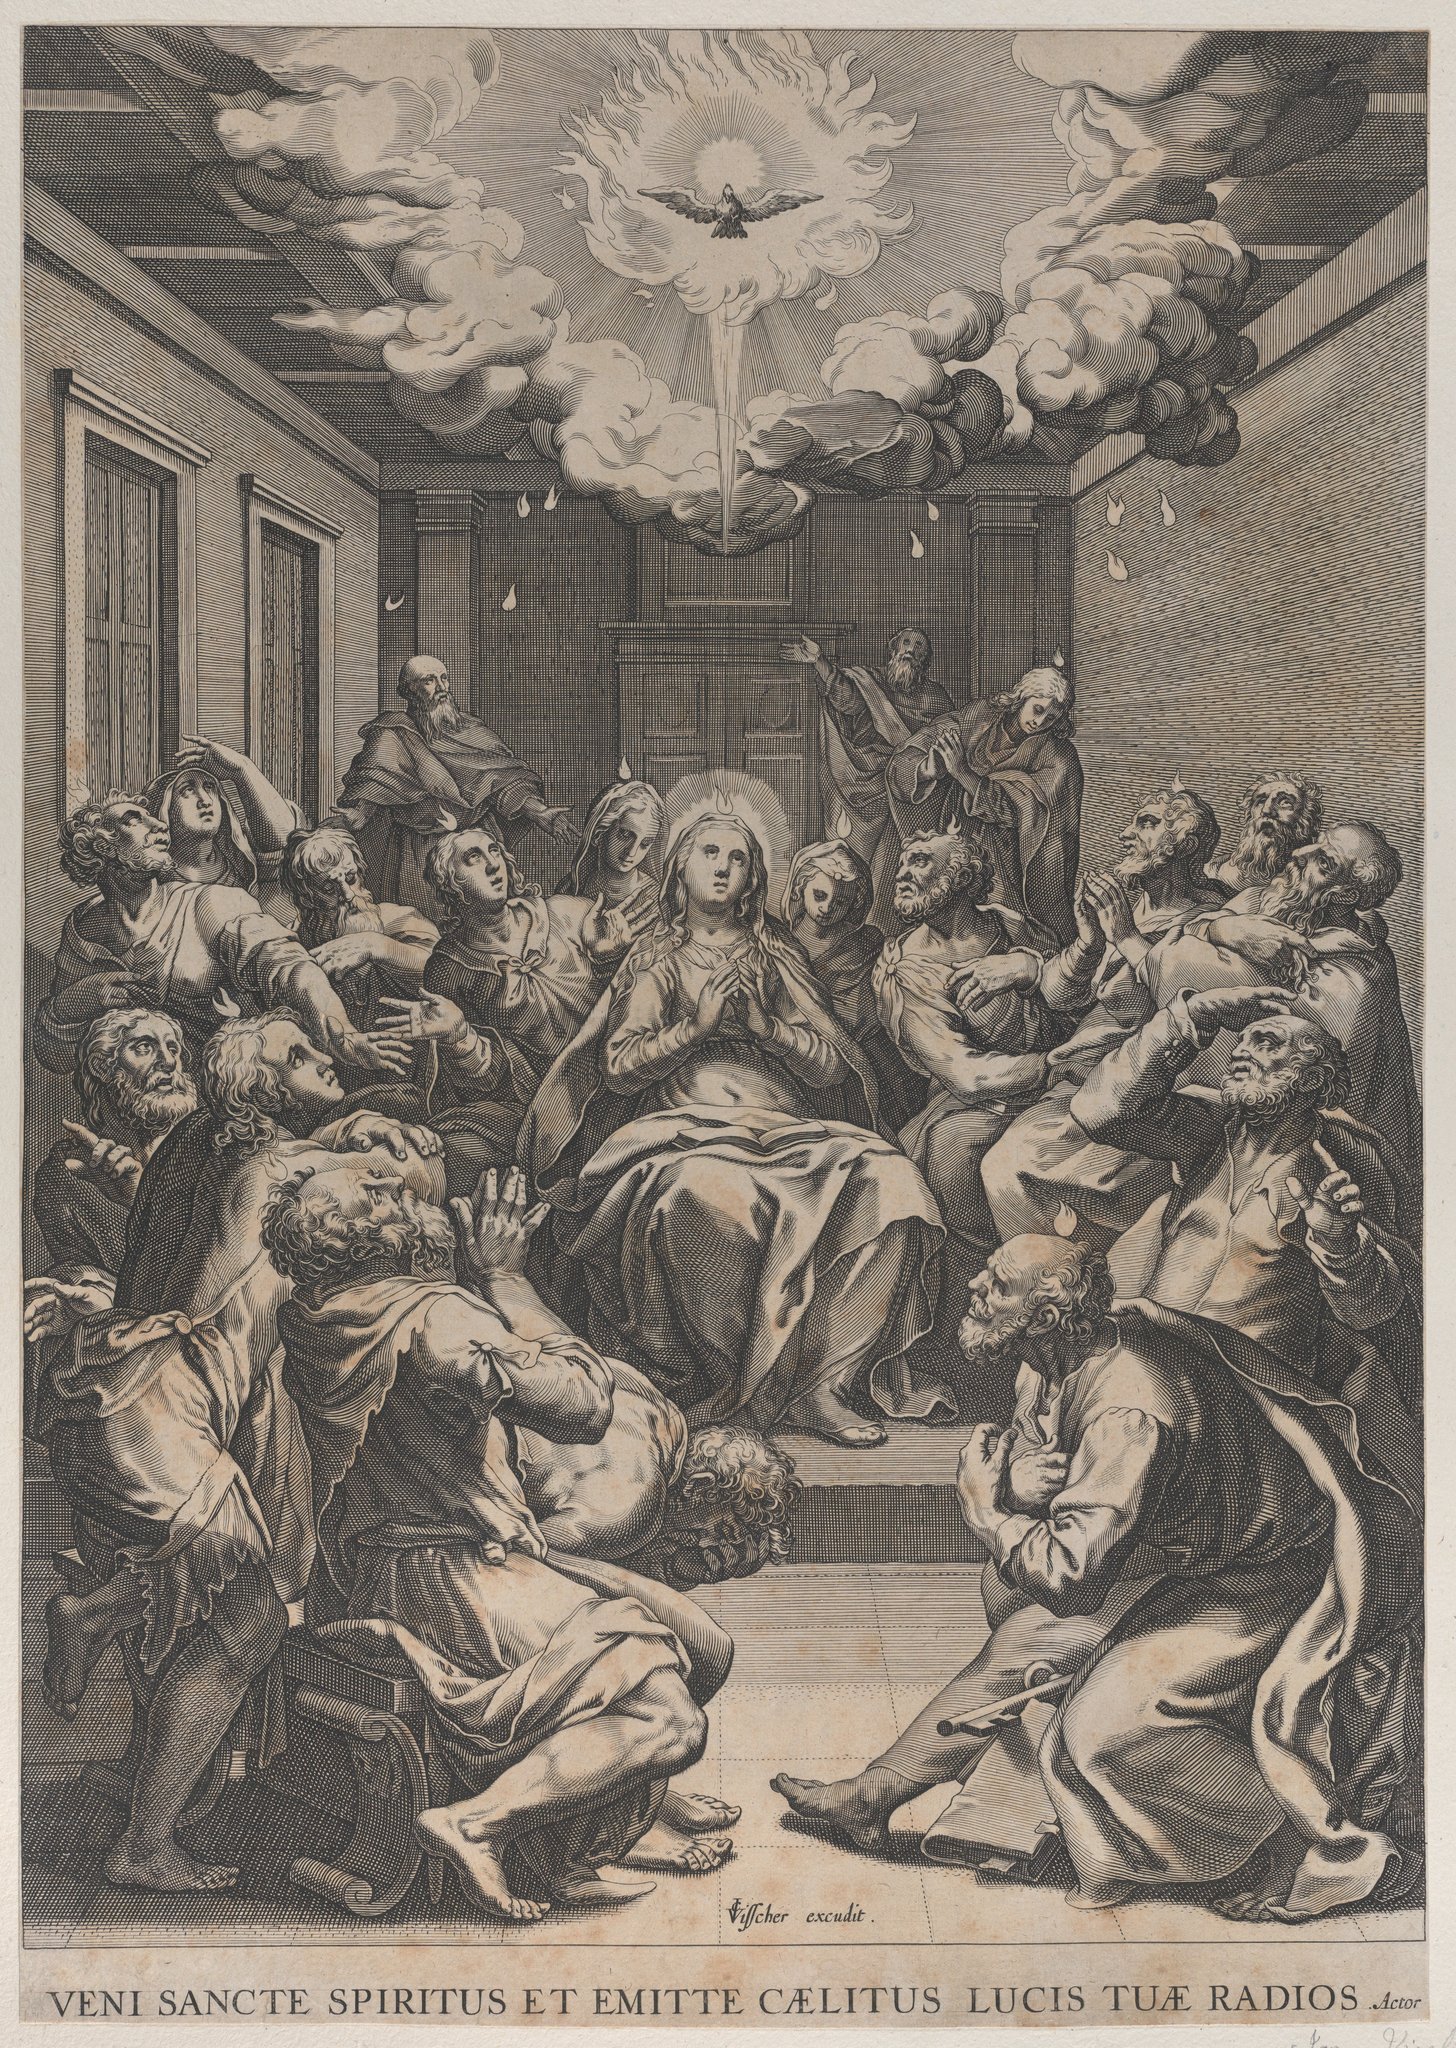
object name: print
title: The Pentecost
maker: claes jansz. visscher (ii)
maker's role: artist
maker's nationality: dutch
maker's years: 1586-1652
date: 1574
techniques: engraving